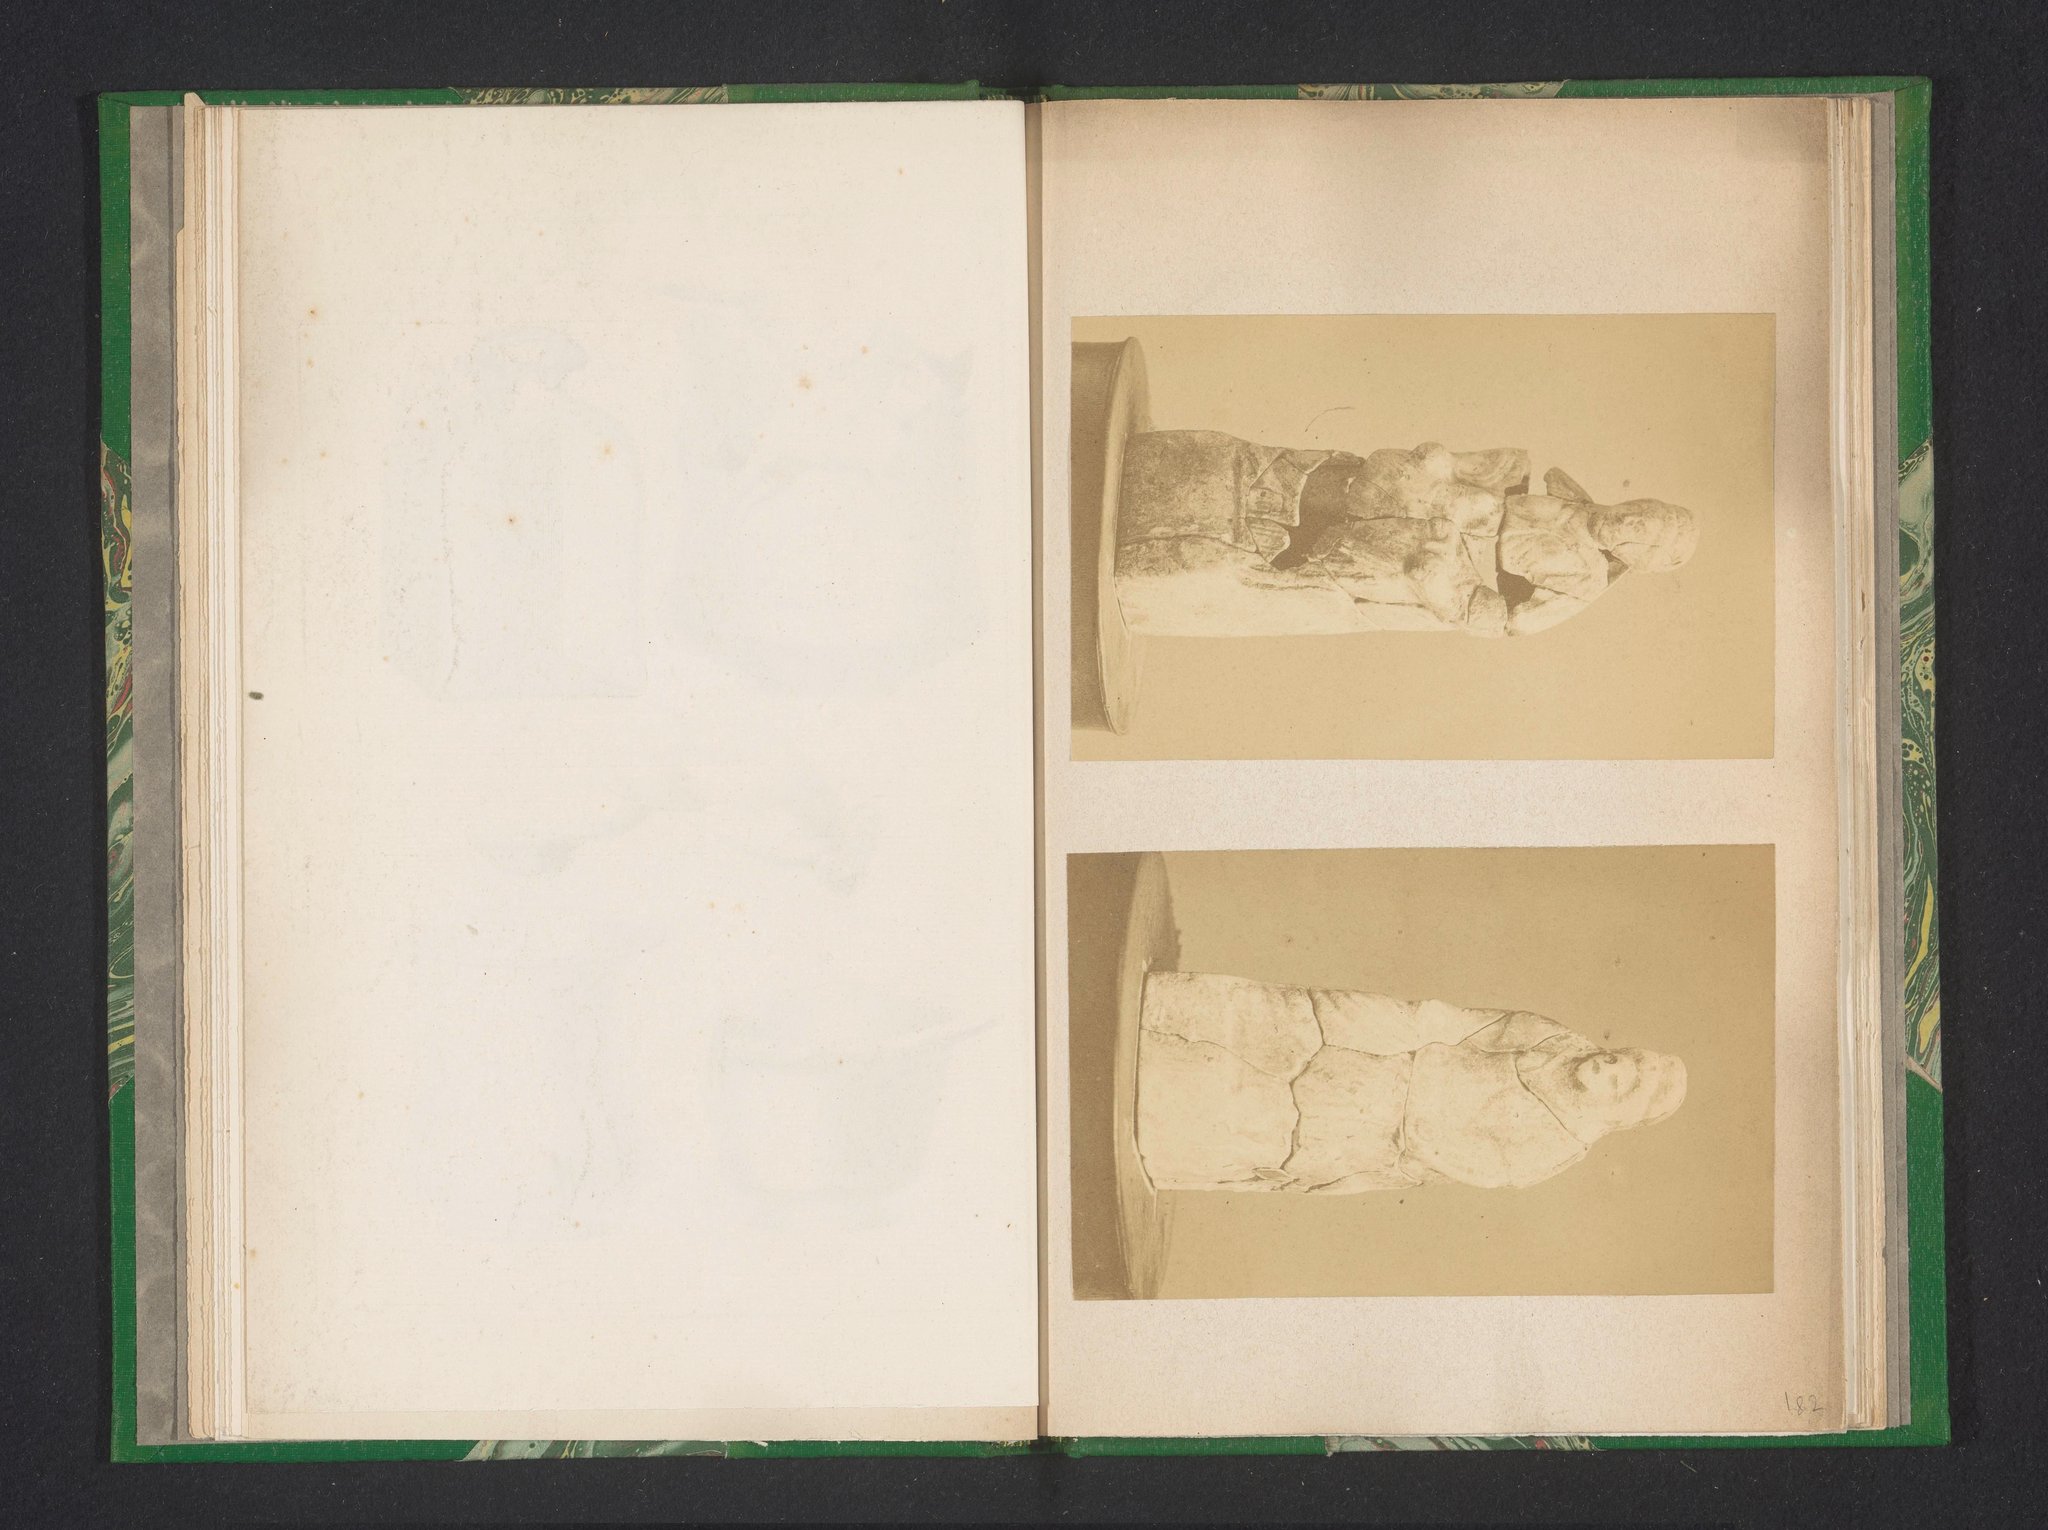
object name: page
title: Gereconstrueerde sculptuur, opgegraven in Juslenville in 1868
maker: Anonymous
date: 1868-1869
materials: photographic support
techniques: albumen print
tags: sculpture